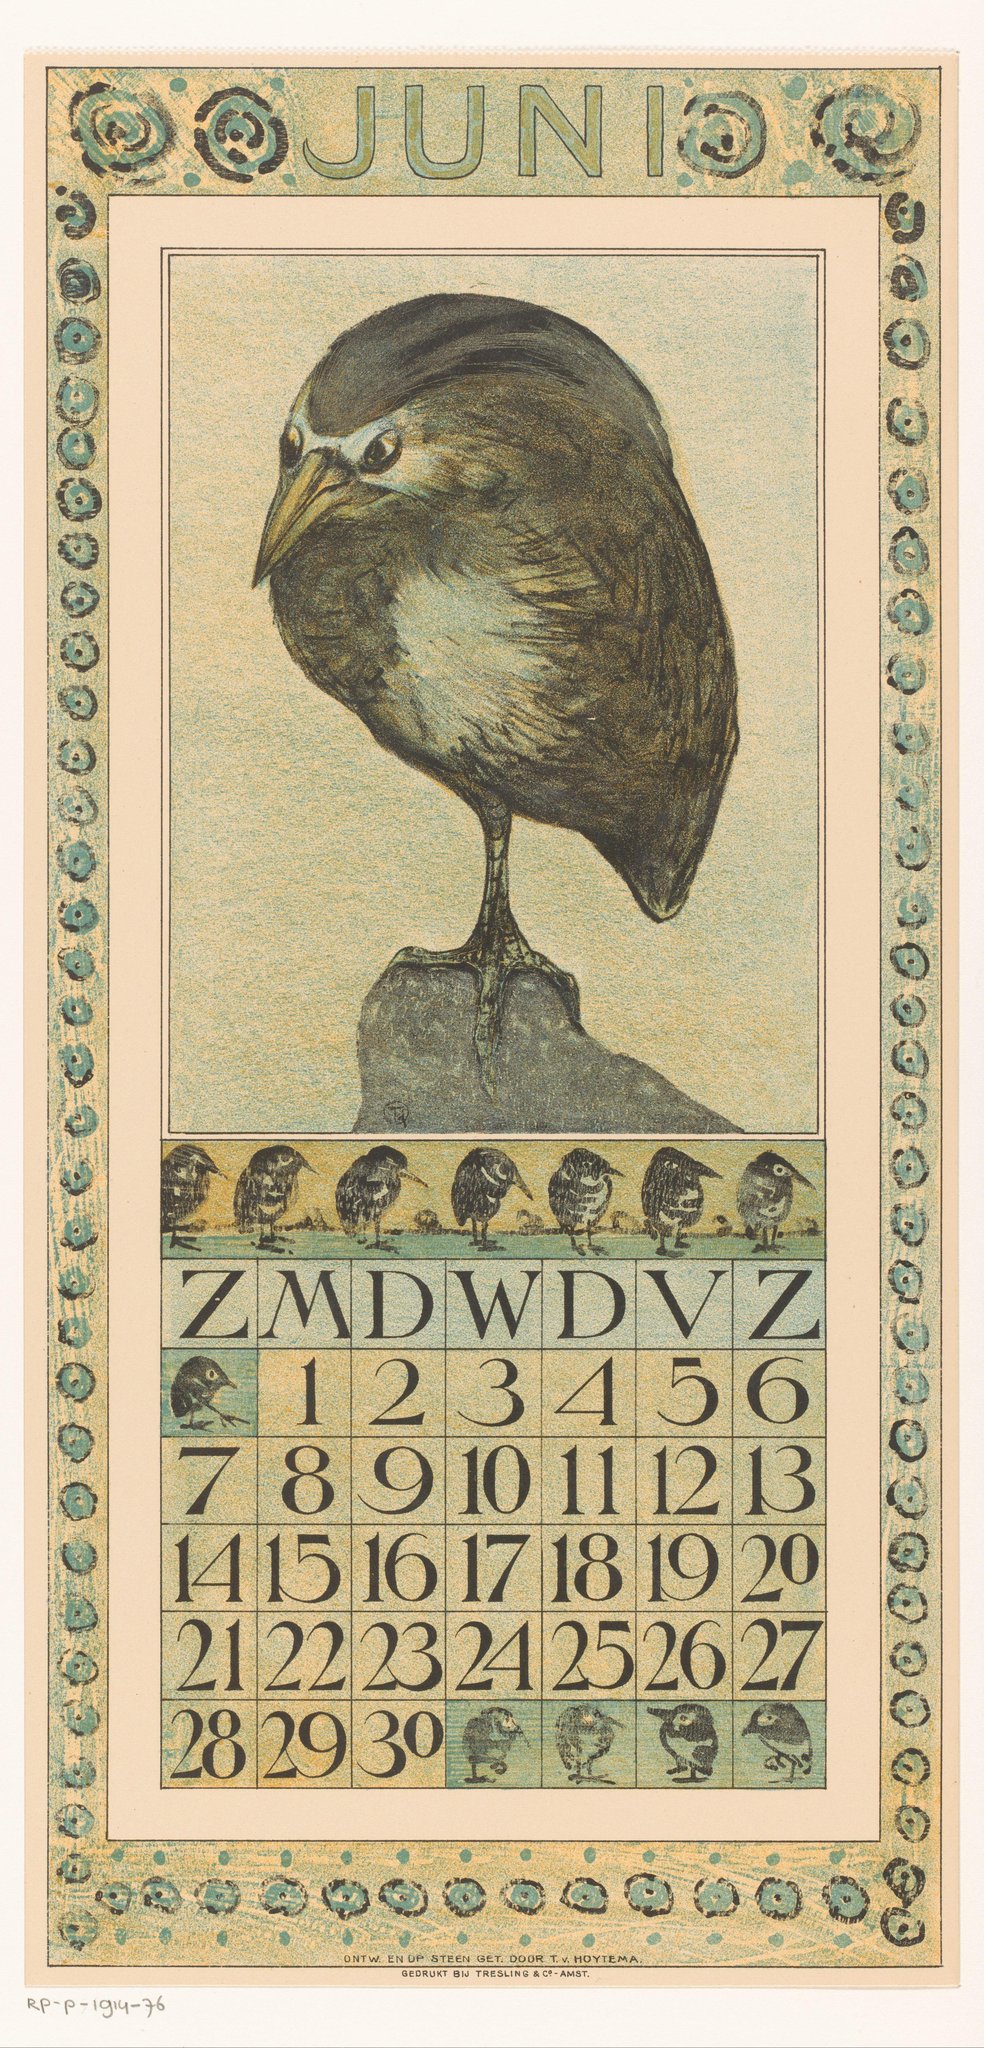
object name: calendar leaf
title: Kalender 1908 12 lithografien door Th. v. Hoytema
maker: theo van hoytema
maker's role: draughtsman, painter, print maker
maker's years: 1863-1917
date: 1907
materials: paper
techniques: lithograph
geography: amsterdam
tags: shore-birds and wading-birds: heron, birds, june ~ other concepts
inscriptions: collector's mark: Lugt 2228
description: De vogel staat op een poot op een steen. Bovenaan het blad een scheurlijn.